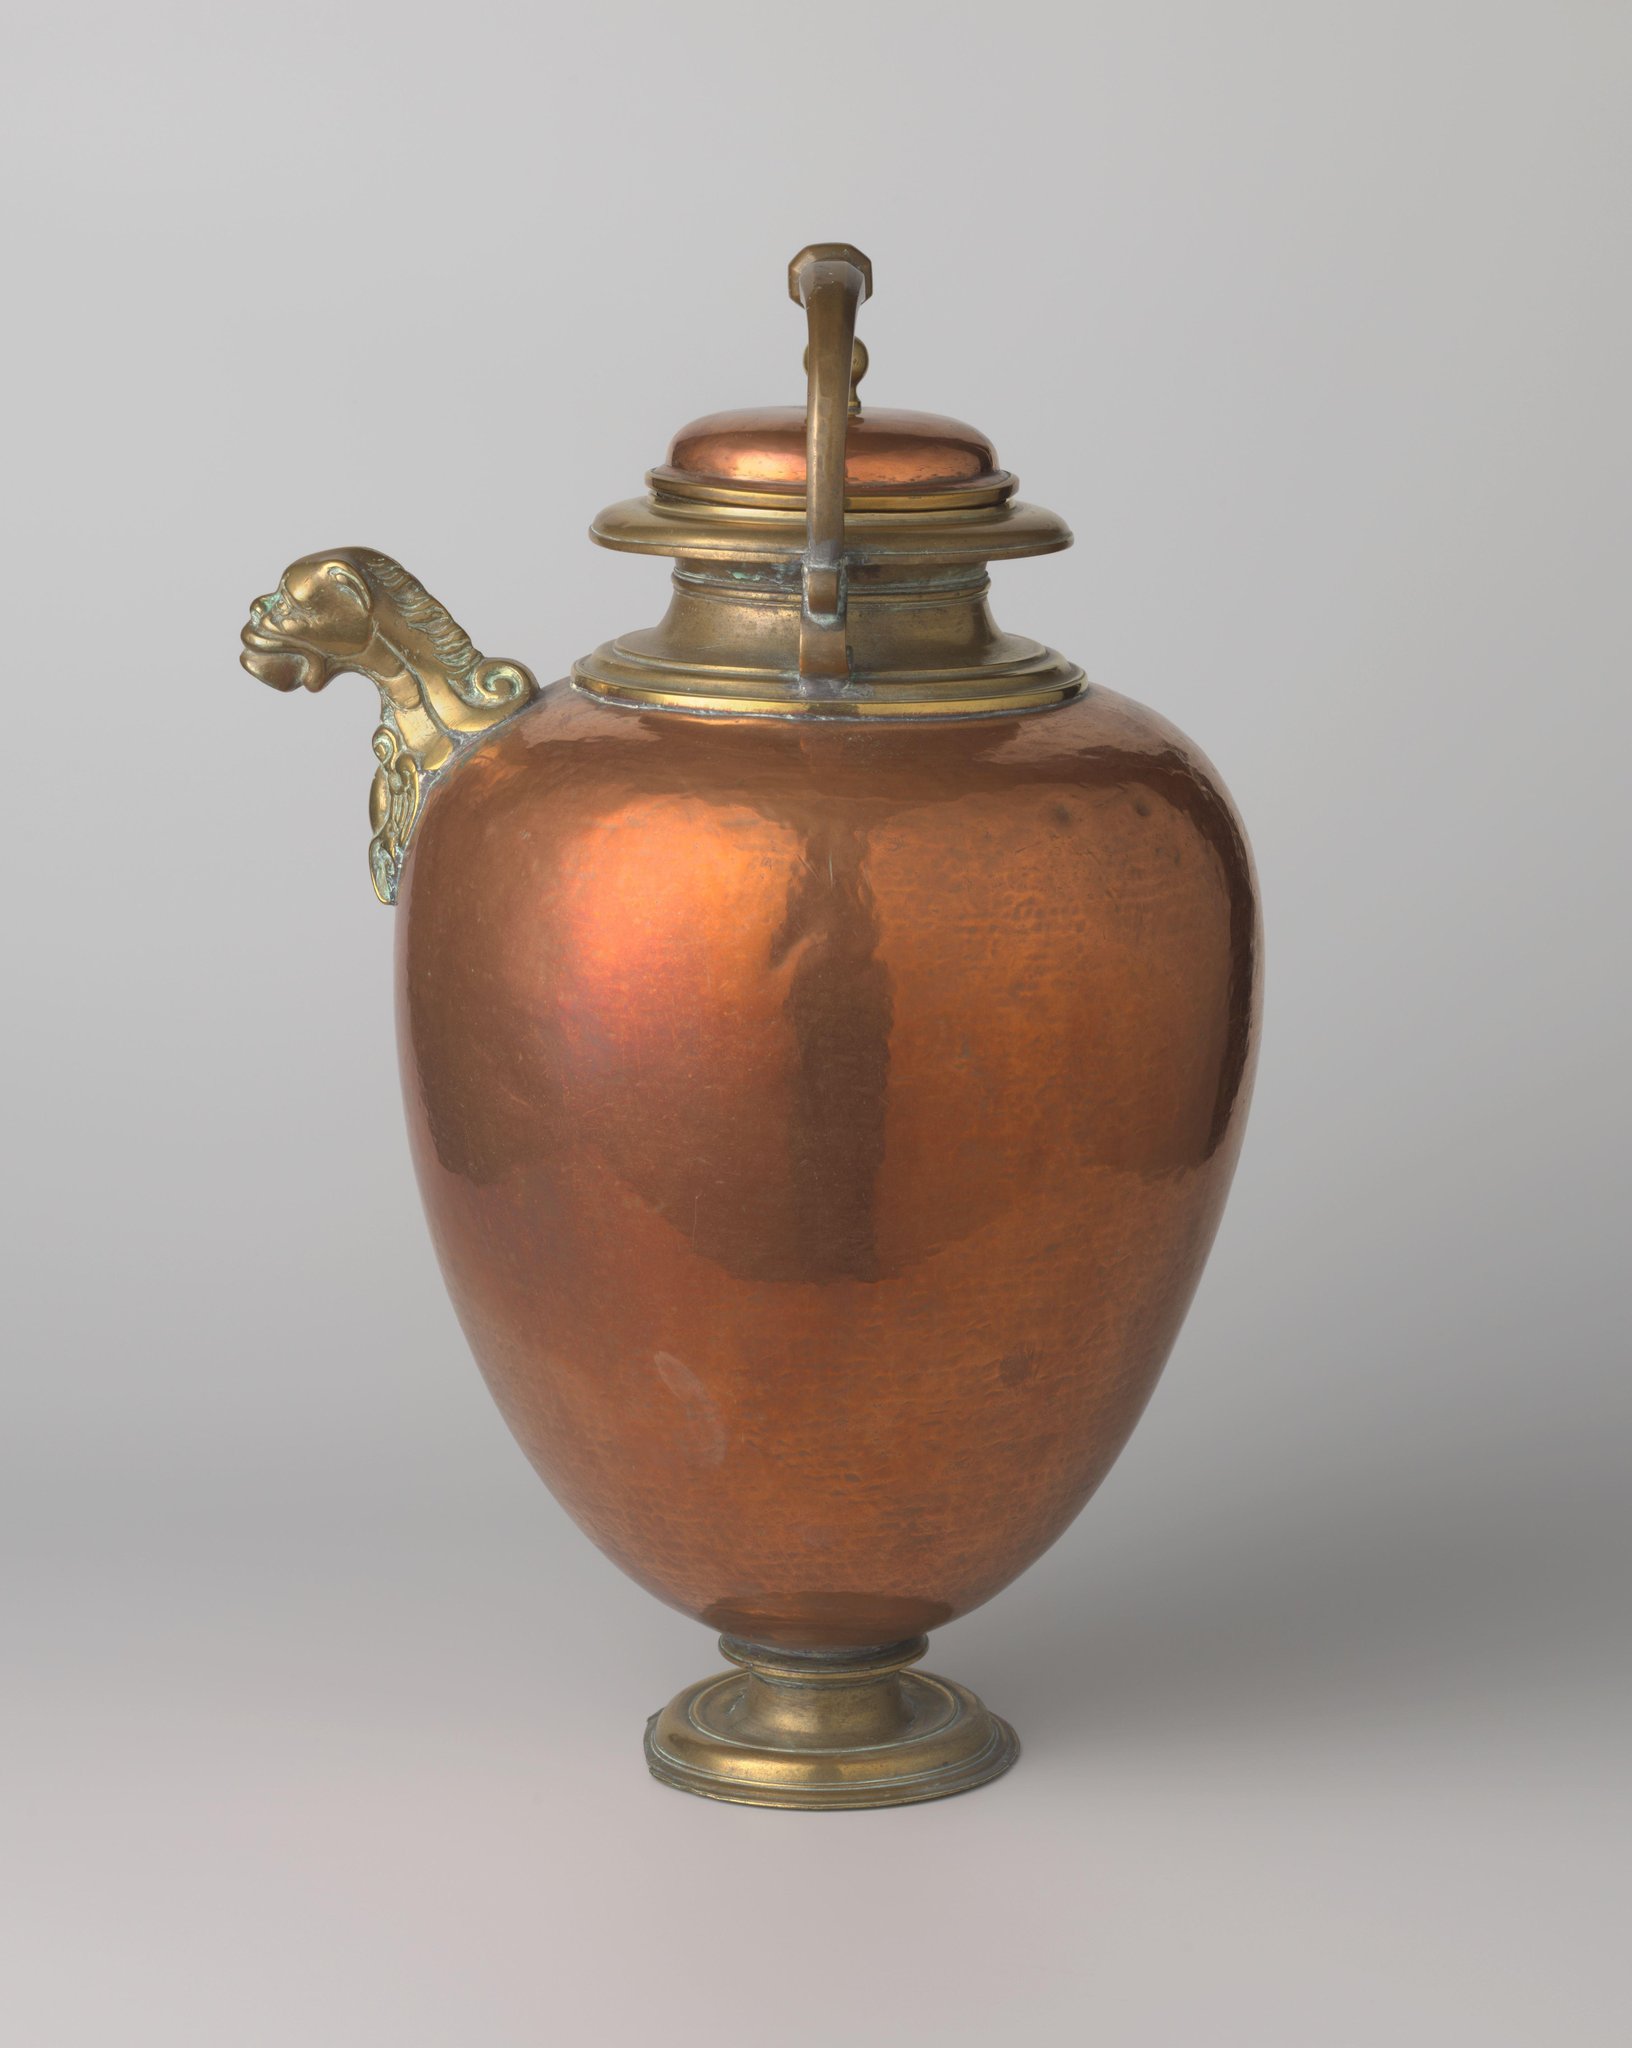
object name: waterkan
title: Waterkan met tuit in vorm van dierenkop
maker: Anonymous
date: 1575-1625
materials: brass, copper, lead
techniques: brazing, casting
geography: italy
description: Het voorwerp is samengesteld uit de volgende delen: het uit rood koperplaat gedreven vat en deksel, de uit geel koper gegoten, met lood verstevigde voet, de tuit, de hals en de dekselknop. De verhoudingsgewijs kleine krachtig geprofileerde ronde voet, die aan de voorkant langs de rand rechts is afgesneden, contrasteert met het onversierde ronde vat, dat onder eivormig en boven plat-bol is. De ronde hals heeft een holronde opbouw met krachtig geprofileerde randen onder- en bovenaan. Daartegen is het ronde hanvat gebraseerd, dat bovenop achtvlakkig is met een geprofileerde nodus in het midden. De met een ronde knop versierde deksel is platbol en glad. De tuit wordt gevormd door een in twee delen gegoten spuwer van geel koper in de vorm van een dierenkop met een cartouche en blank schild.